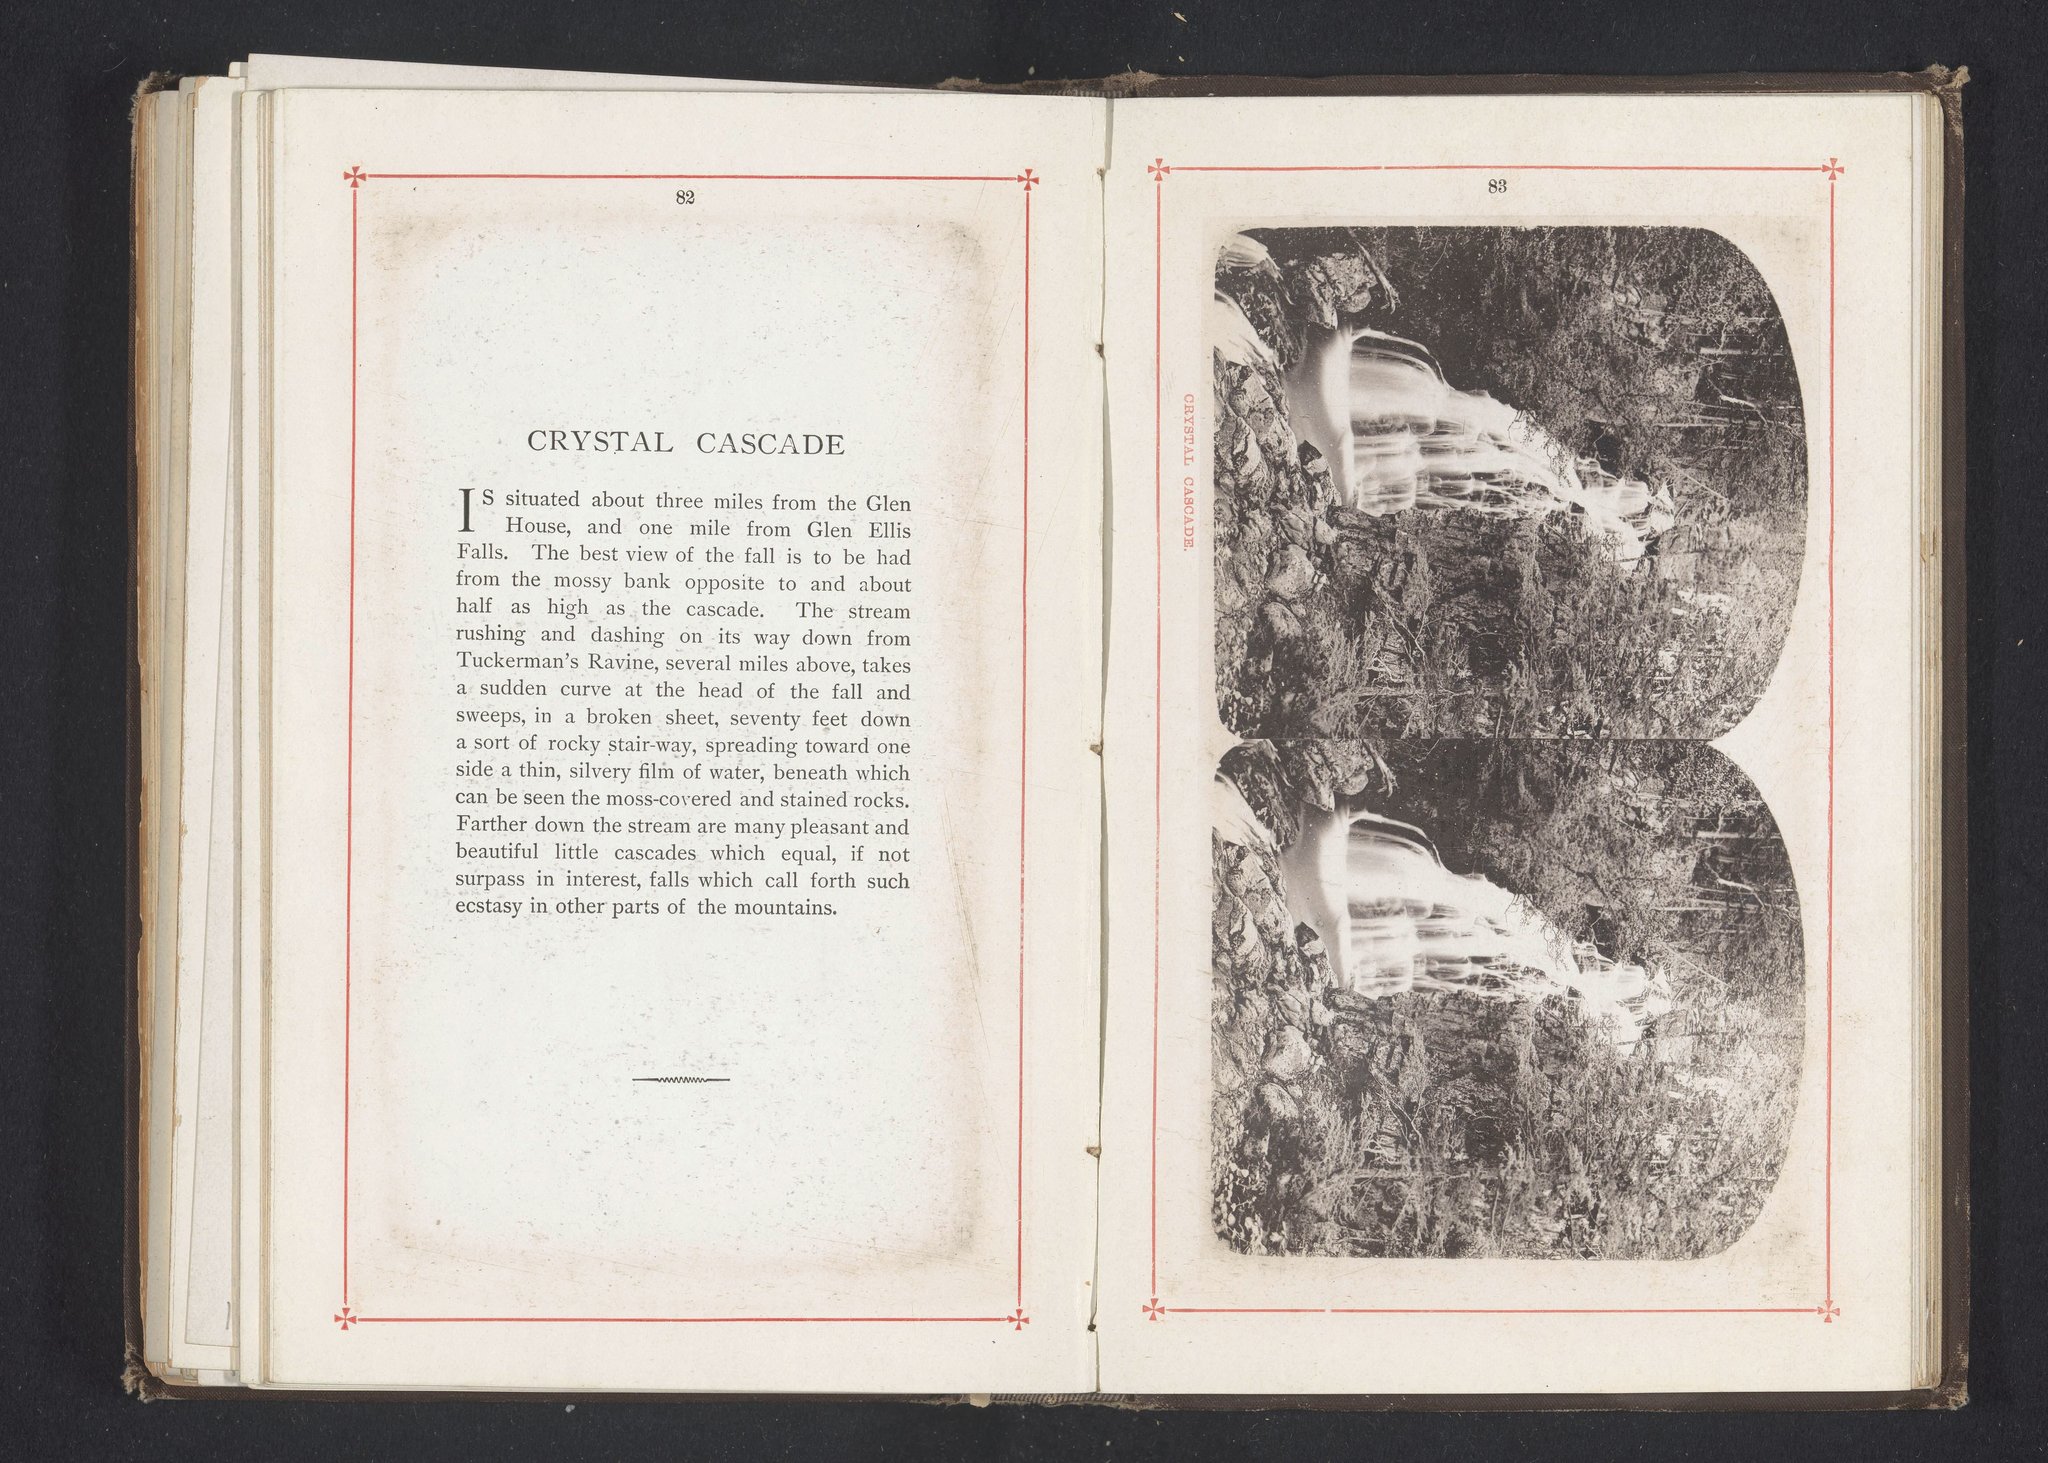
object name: photomechanical print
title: Gezicht op een waterval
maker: Anonymous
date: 1873-1878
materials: paper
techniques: photograph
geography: coos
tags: waterfall, forest, wood